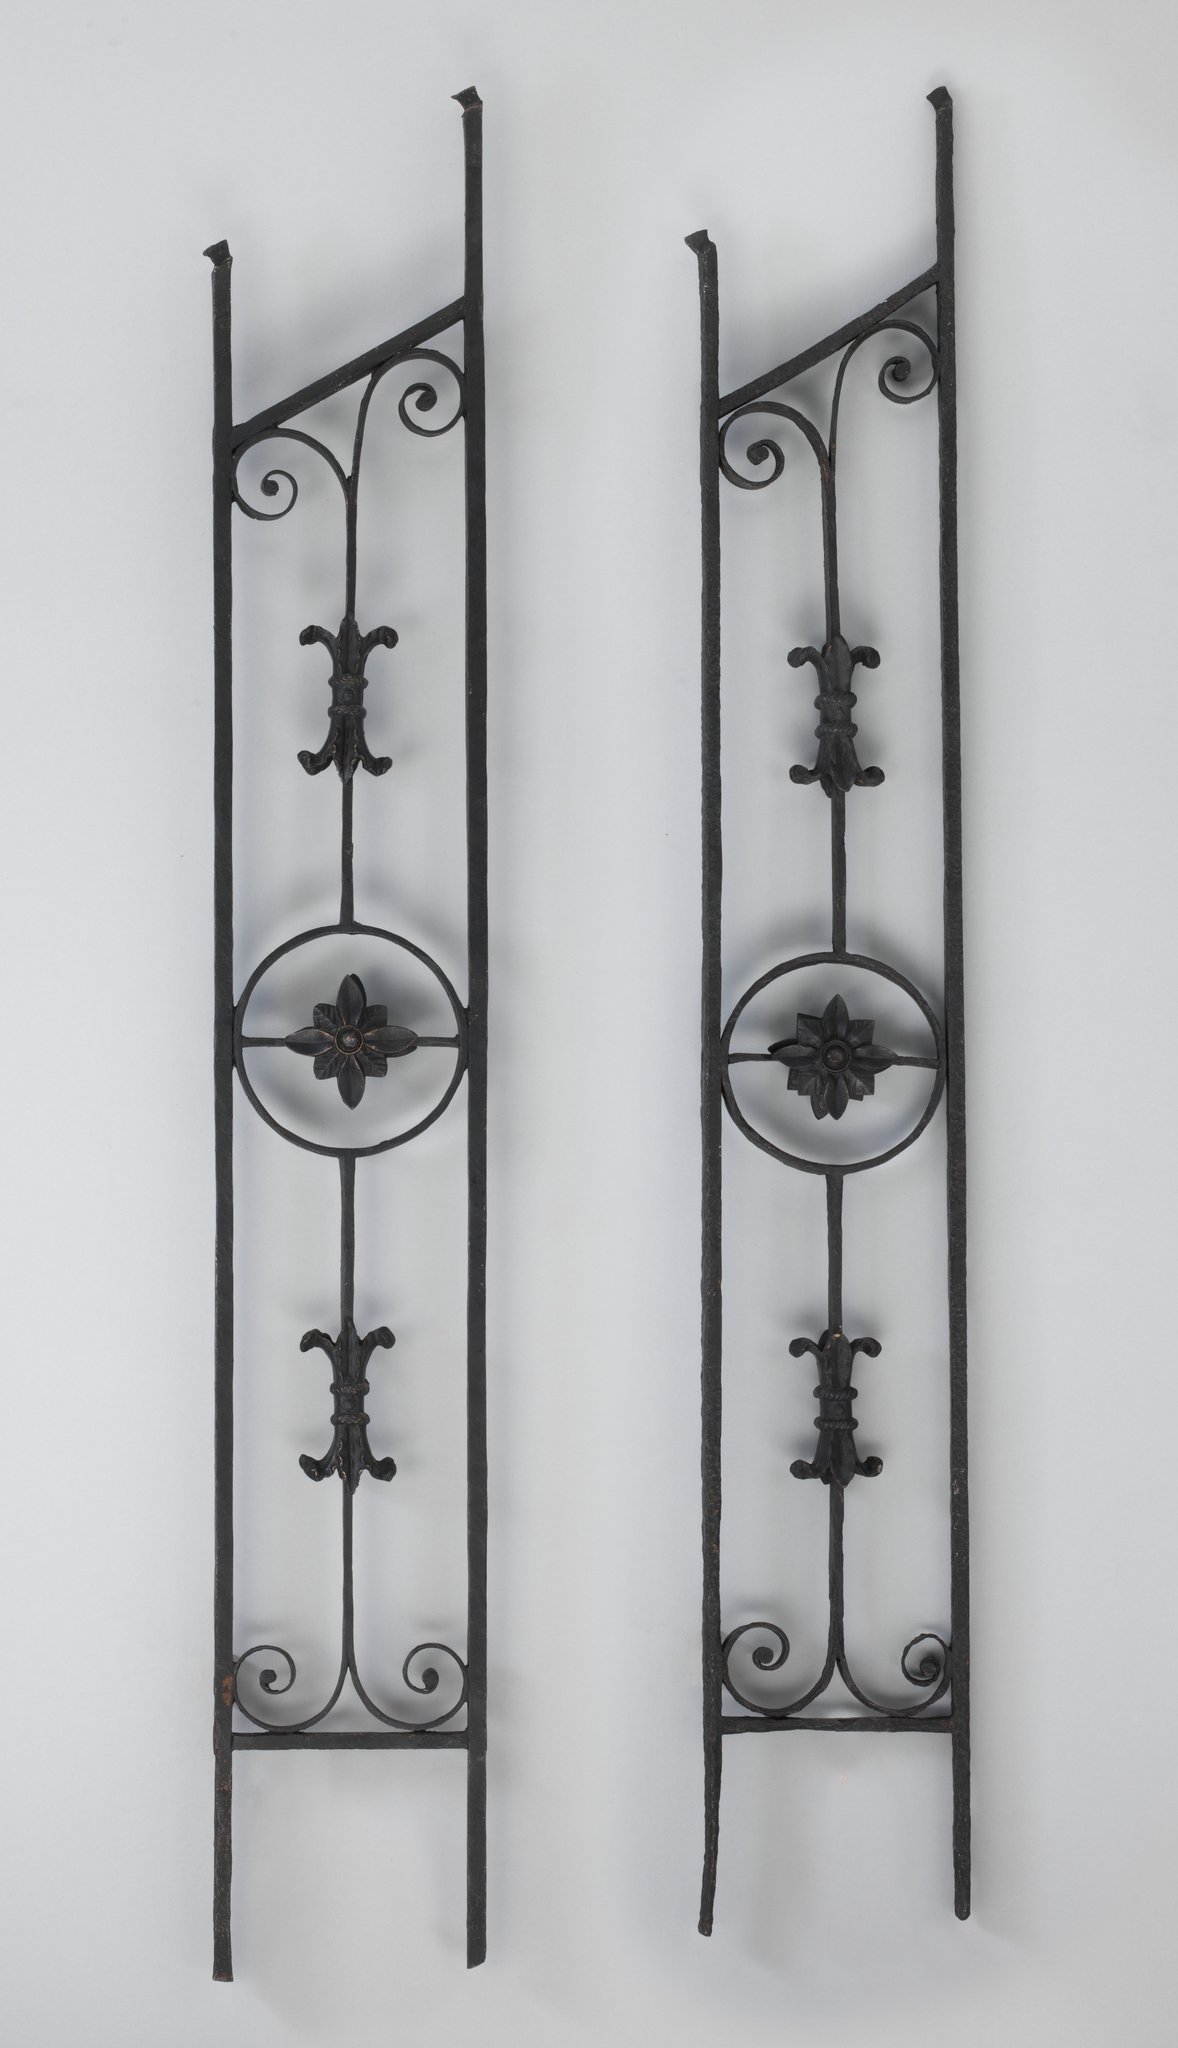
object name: baluster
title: Iron baluster (one of a pair)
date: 1780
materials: brass, iron